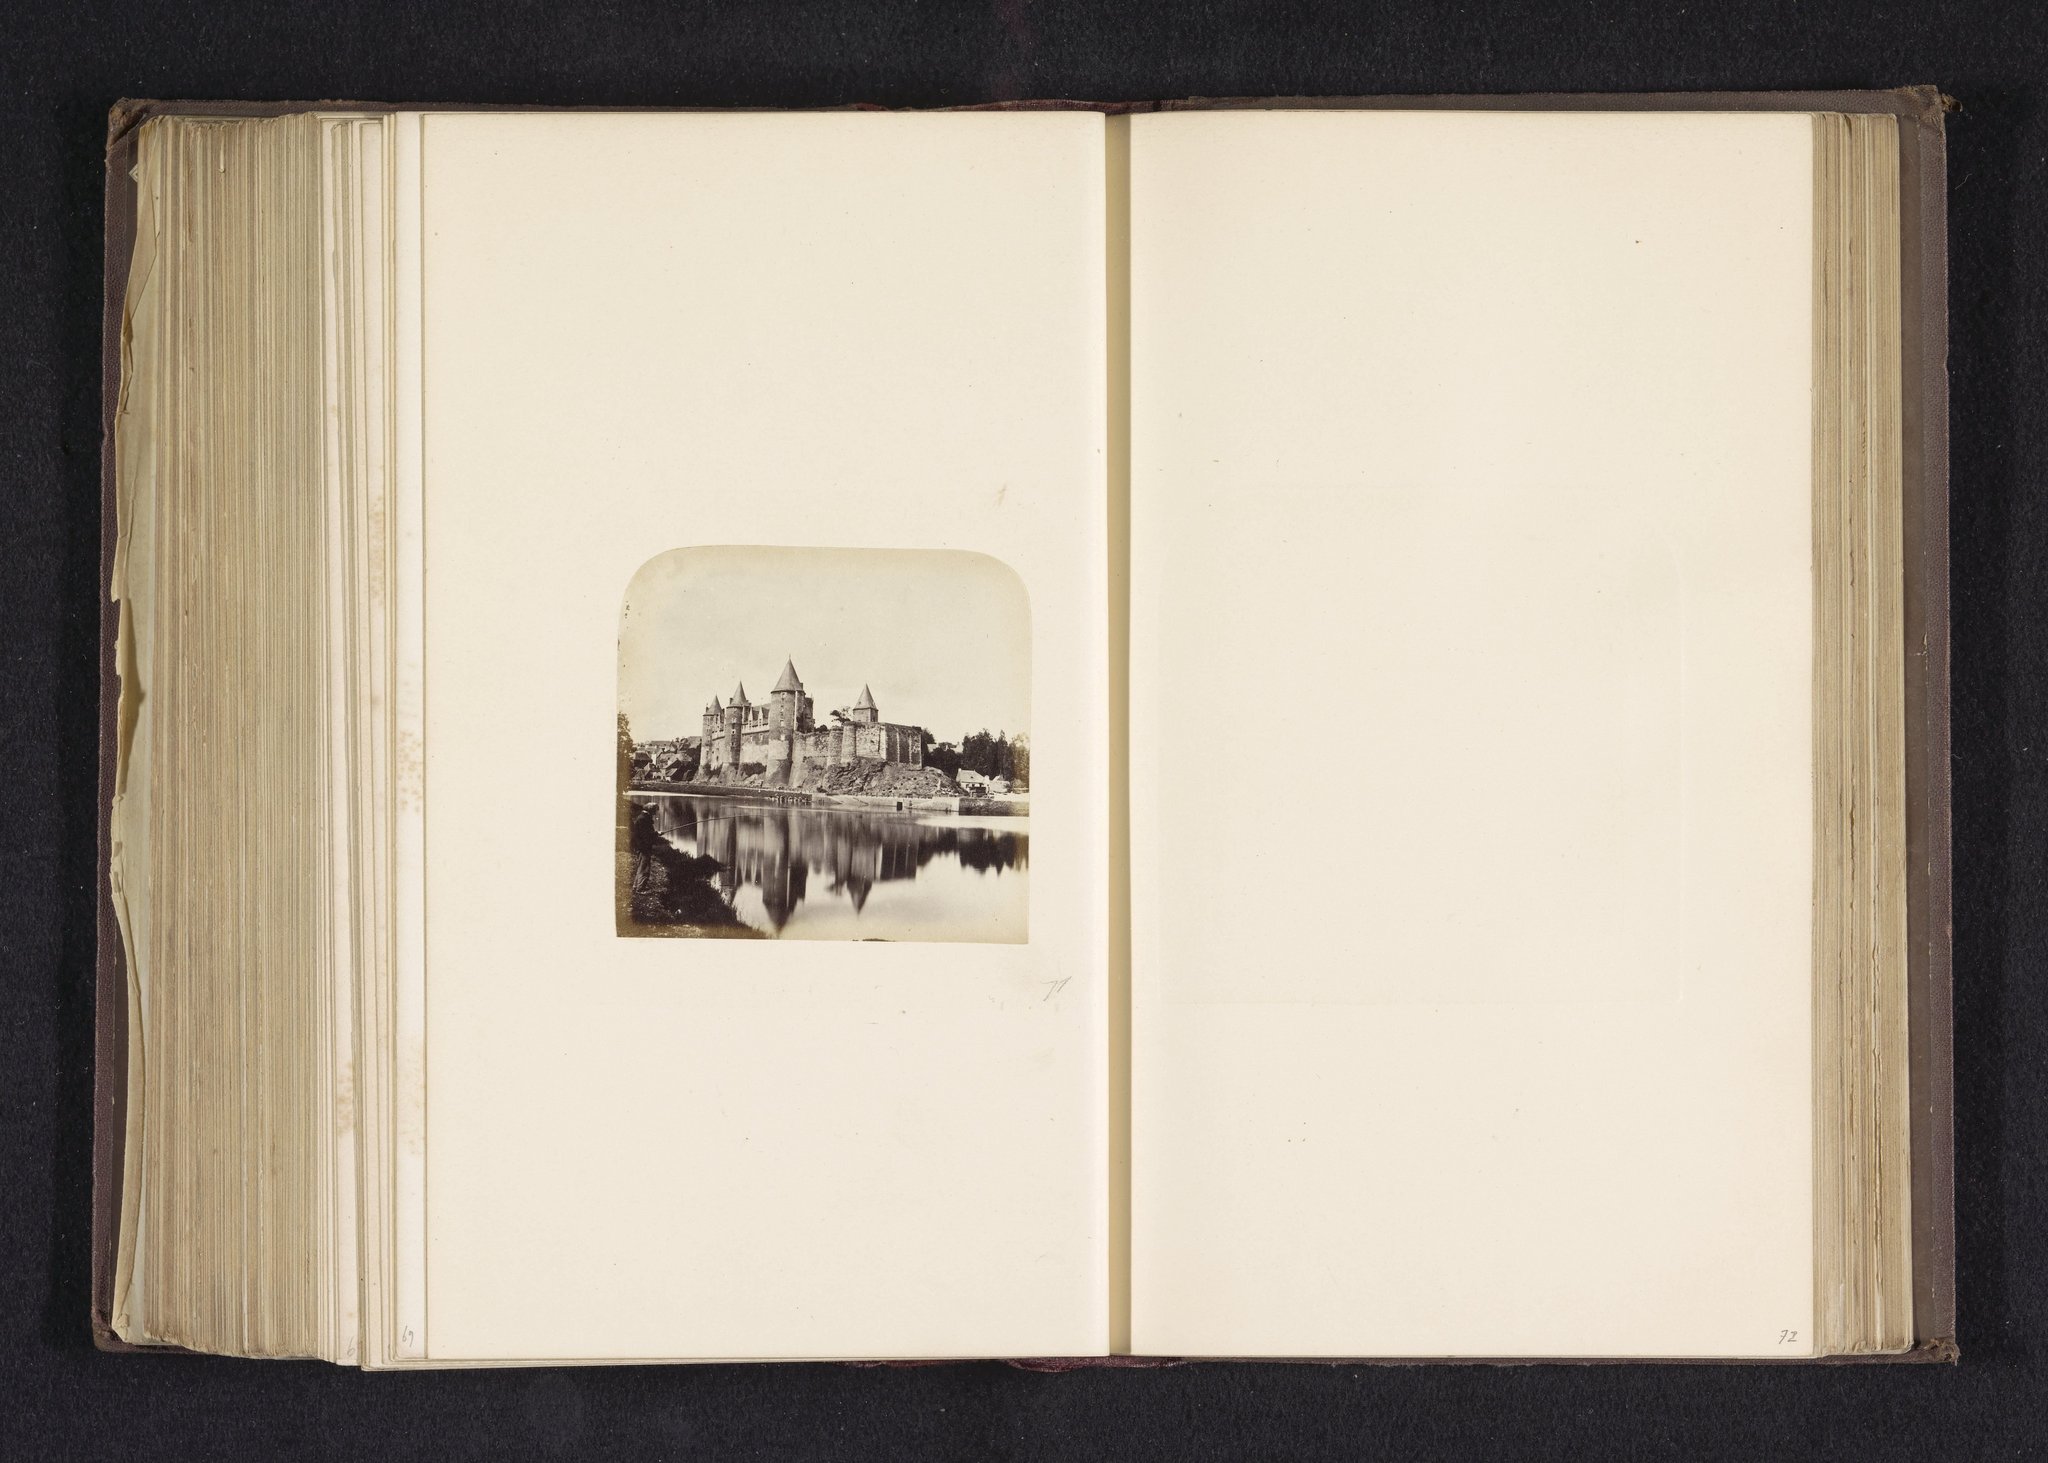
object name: page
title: Gezicht op het kasteel van de Prince de Léon in Josselin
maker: taylor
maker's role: fotograaf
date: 1850-1859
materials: photographic support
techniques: albumen print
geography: josselin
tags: castle, lake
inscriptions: number: ‘71’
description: Foto op zesde ongenummerde pagina na pagina 236.